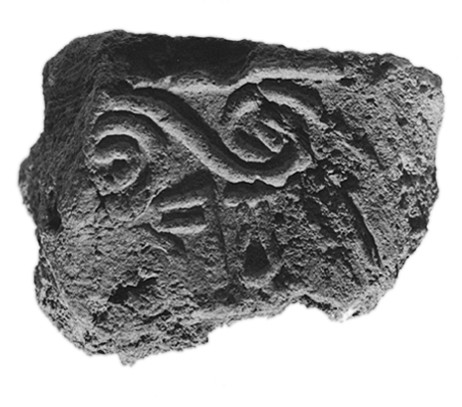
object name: sealing fragment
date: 2030-1640 BCE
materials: clay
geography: egypt